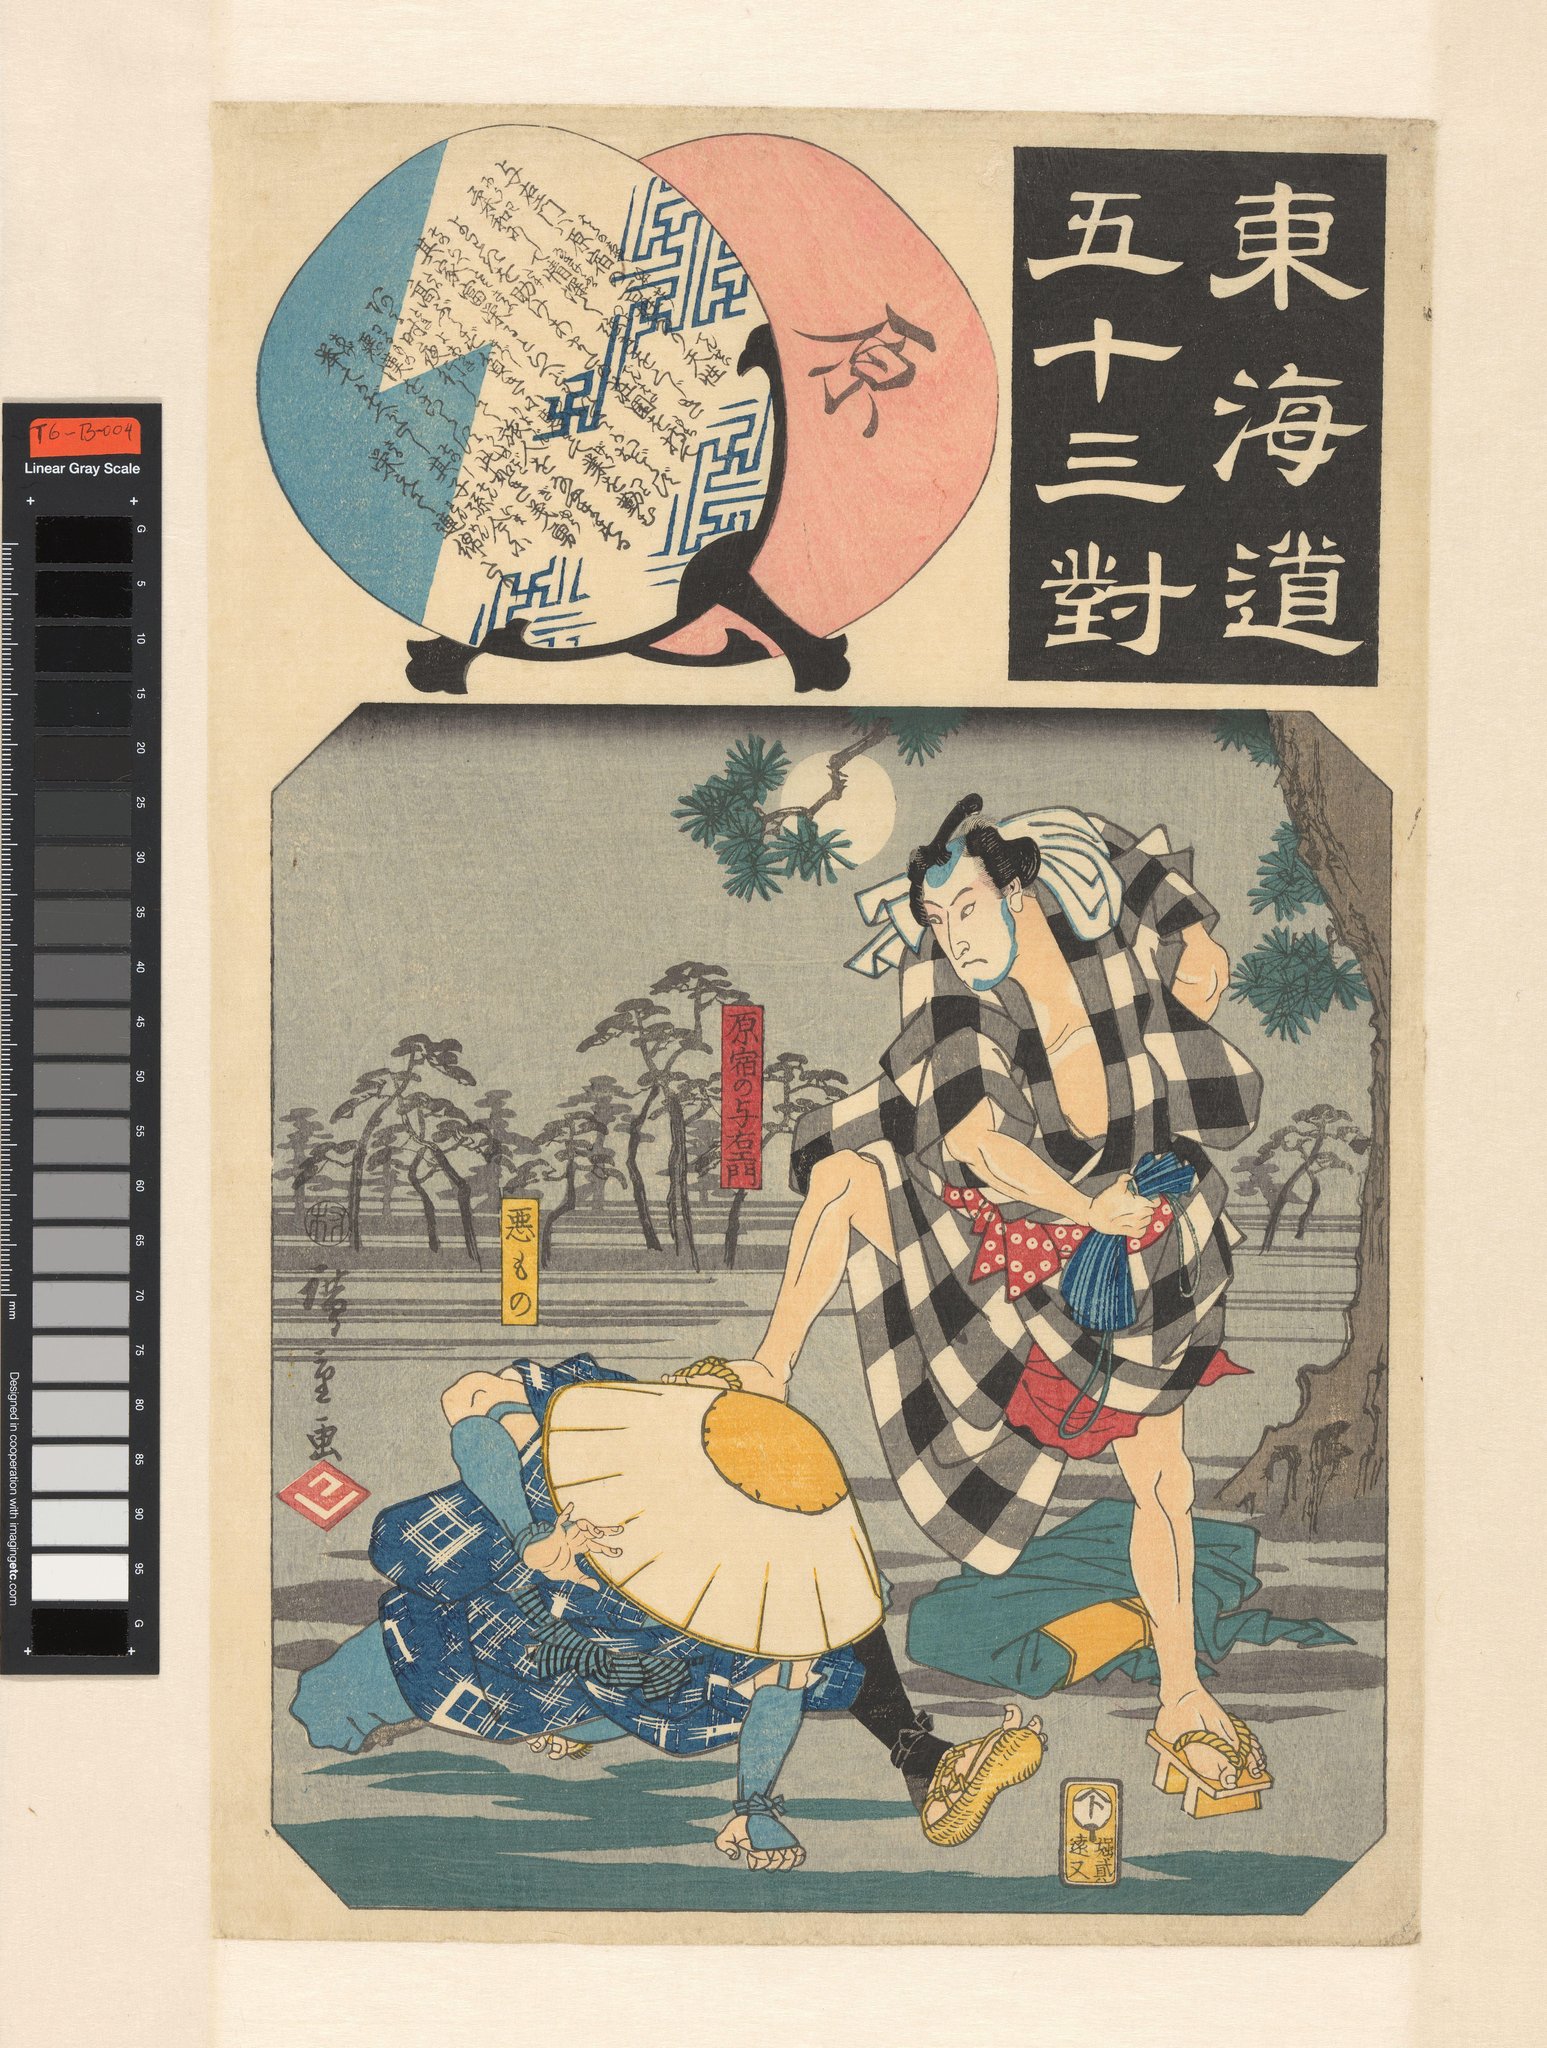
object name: print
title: Fifty-three parallels for the Tokaido road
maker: utagawa hiroshige (i)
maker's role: draughtsman, print maker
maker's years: 1797-1858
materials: paper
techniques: woodcut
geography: japan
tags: kicking, farmers, night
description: Harajuku Yoemon, een boer in zwart-wit geruit gewaad, slaat op een maanverlichte nacht de schurk Warumono in elkaar, omdat hij reizigers lastig viel.